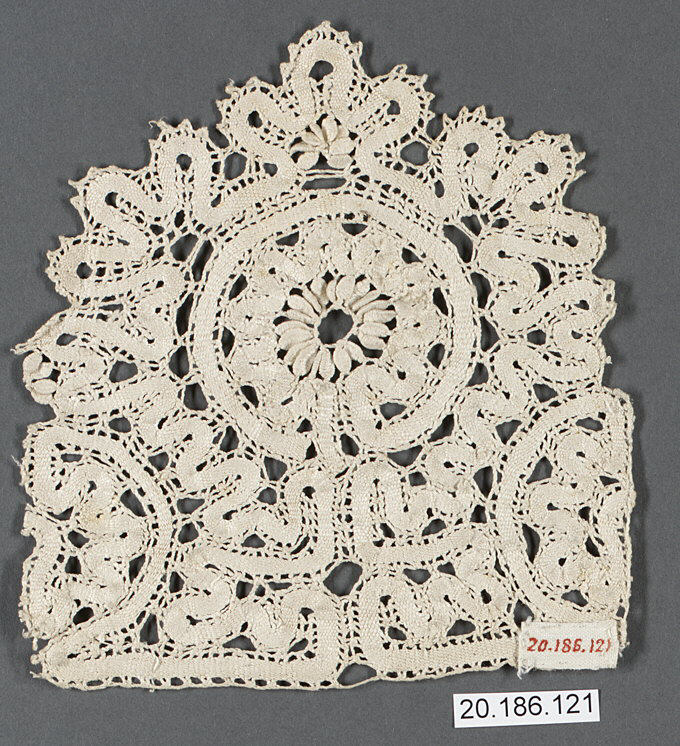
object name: fragment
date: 1601-1700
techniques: lace